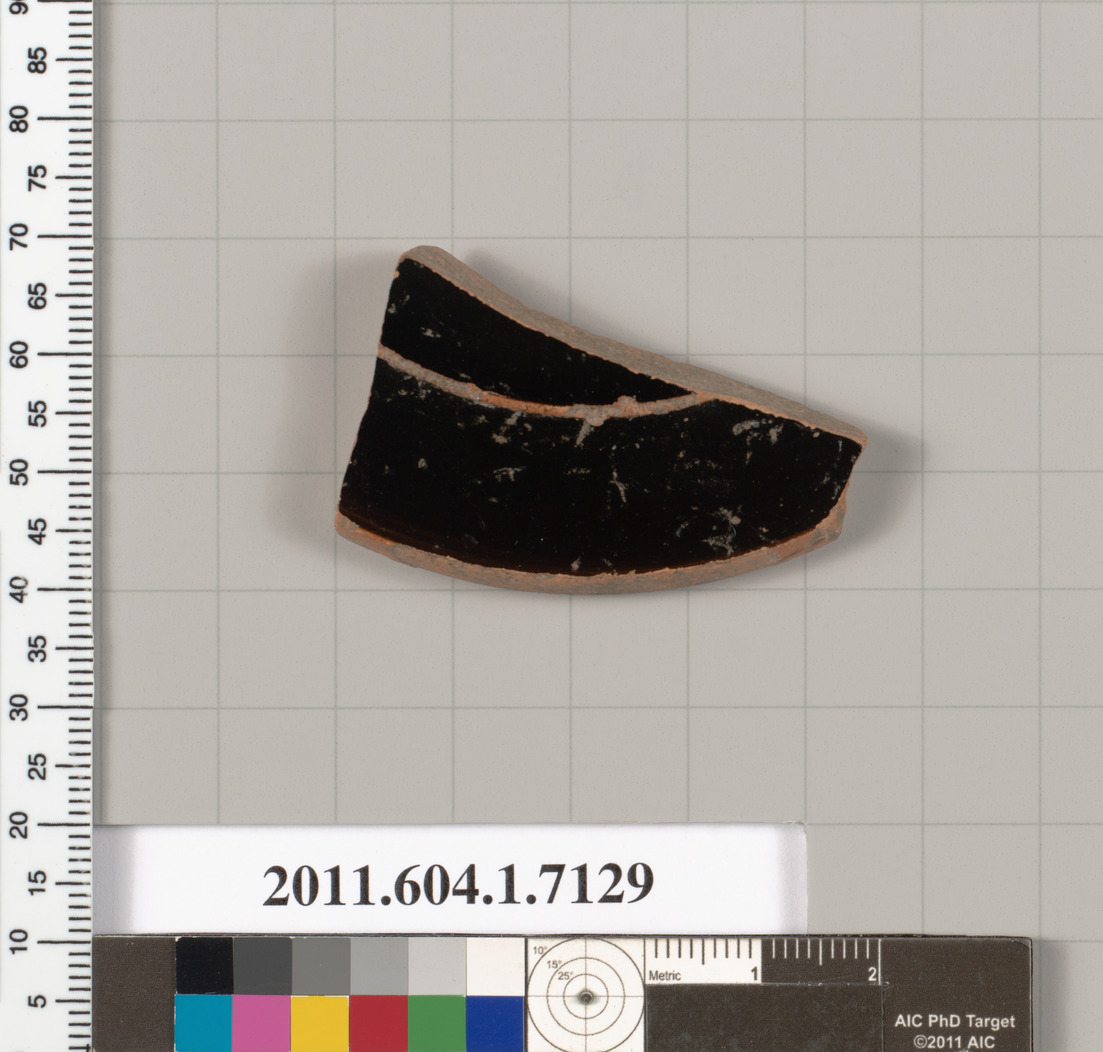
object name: kylix fragment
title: Terracotta fragment of a kylix (drinking cup)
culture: greek, attic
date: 475-451 BCE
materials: terracotta